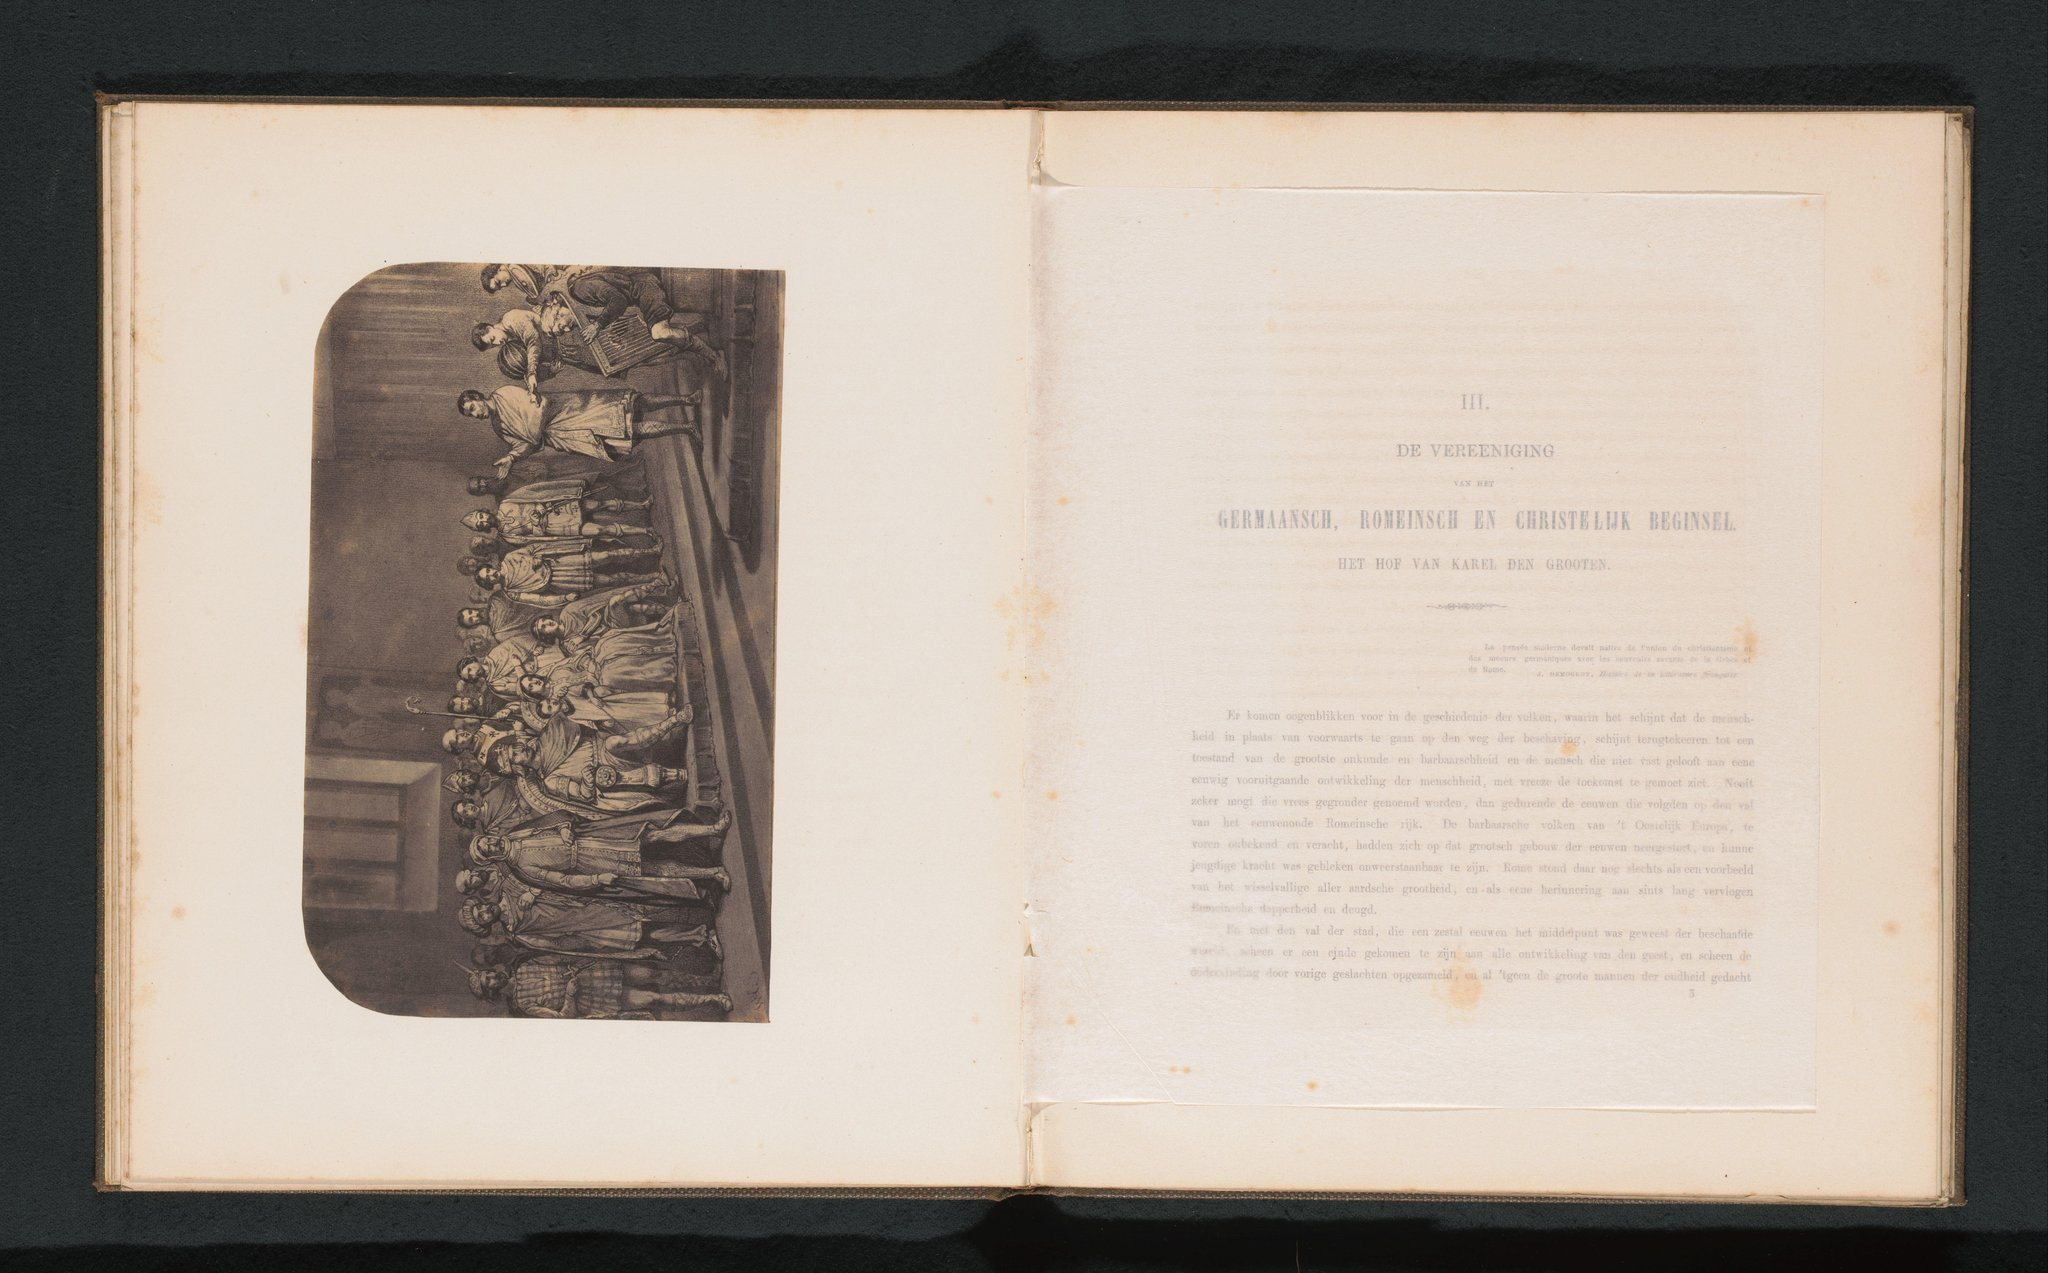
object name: page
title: Fotoreproductie van een prent van een bijeenkomst van het hof van Karel de Grote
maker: Anonymous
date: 1856-1861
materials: photographic support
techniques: albumen print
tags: charlemagne (holy roman emperor), family of a ruler, and court, emperor